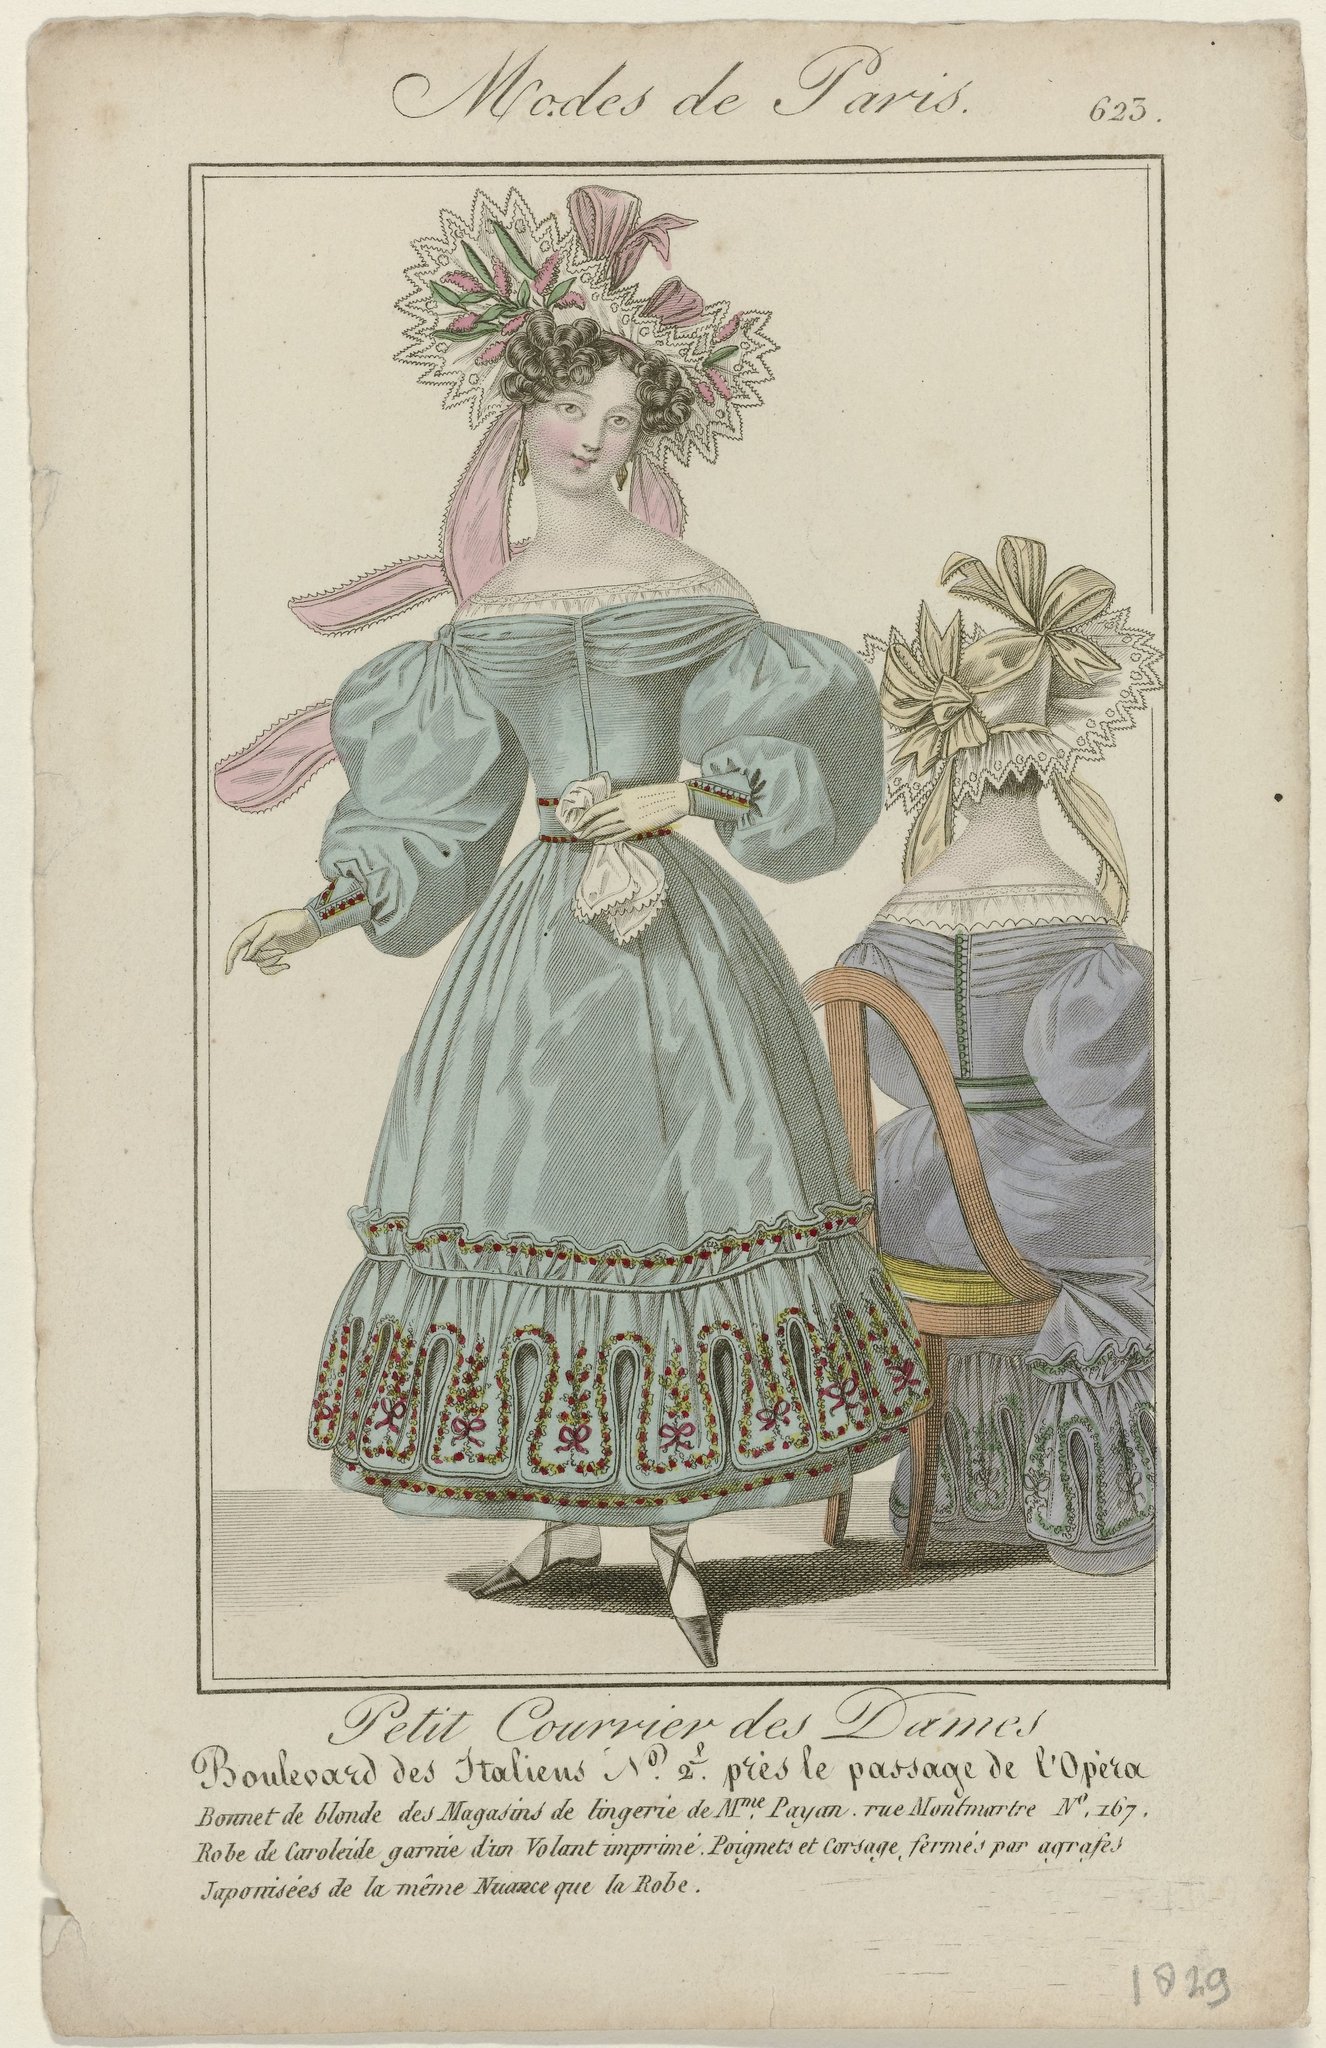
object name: fashion print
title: Petit Courrier des Dames, 1829, No. 623 : Bonnet de blond (...)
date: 1829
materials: paper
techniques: engraving, hand coloring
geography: paris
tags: ear-rings (+ women's clothes), handkerchief (+ women's clothes), brooch, agraffe, clasp (+ women's clothes), ornamental parts of clothing (+ women's clothes), head-gear: cap (+ women's clothes), fashion plates, gloves, mittens, etc. (+ women's clothes), dress, gown (+ women's clothes), shoes, sandals, sleeves (+ women's clothes)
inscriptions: caption: ‘Bonnet de blonde des Magasins de lingerie de M.me Payan, rue Montmartre No. 167. Robe de Caroleide garnie d'un Volant imprimé. Poignets et corsage, fermés par agrafes Japonisées de la même Nuance que la Robe.’, title: ‘Petit Courrier des Dames.’, title: ‘Modes de Paris.’, address: ‘Boulevard des Italiens No.2 près le passage de l'Opèra.’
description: Muts van Blonde (kloskant) uit de winkels van Paysan. 'Robe de Caroleide' of japon gegarneerd met een volant bedrukt met bloemmotief. De manchetten en het lijfje zijn gesloten met 'agrafes Japonisées' in dezelfde tint als de japon. Verdere accessoires: oorbellen, handschoenen, zakdoek, platte schoenen met gekruiste banden (cothurnes). Prent uit het modetijdschrift Petit Courrier des Dames (1821-1868).